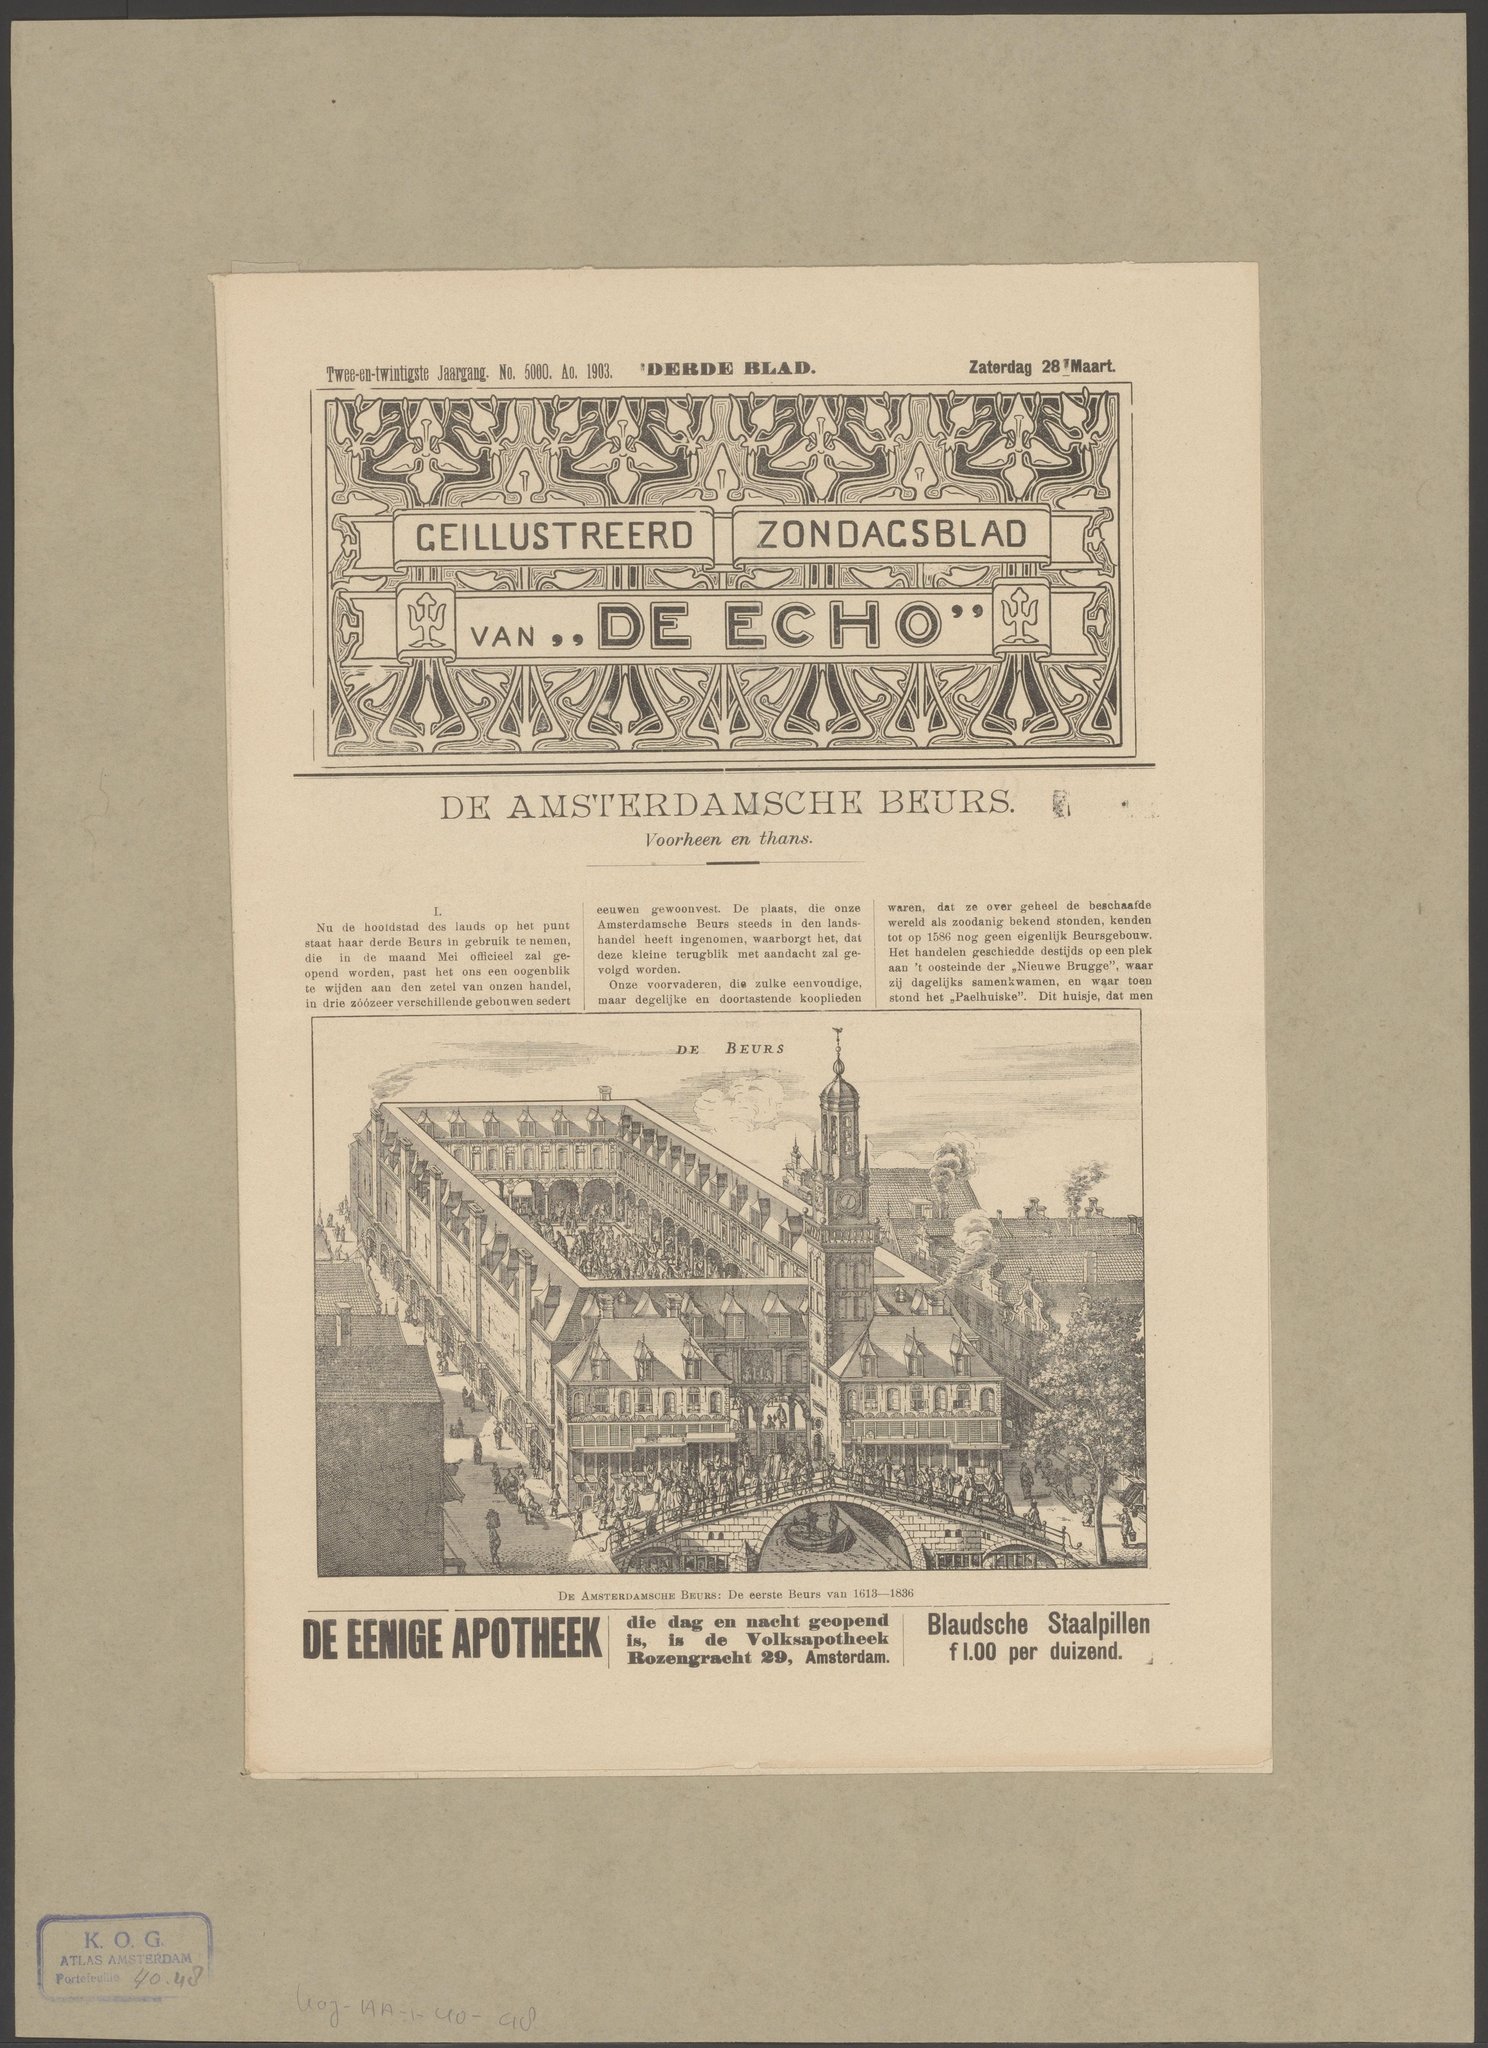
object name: titelblad, titelpagina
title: Titelpagina van: Geïllustreerd Zondagsblad van "De Echo", 28 maart 1903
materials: paper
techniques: letterpress printing, line block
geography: amsterdam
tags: bridge in city across river, canal, etc. (+ city(-scape) with figures, staffage), stock exchange, stock-market, street (+ city(-scape) with figures, staffage)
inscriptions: collector's mark: Lugt 1641b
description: Incomplete exemplaren van: Geïllustreerd Zondagsblad van "De Echo" 22 (1903), nr. 5000, 28 maart 1903, p. 97-100 / Geïllustreerd Zondagsblad van "De Echo" 22 (1903), nr. 5001, 4 april 1903, p. 105-108.